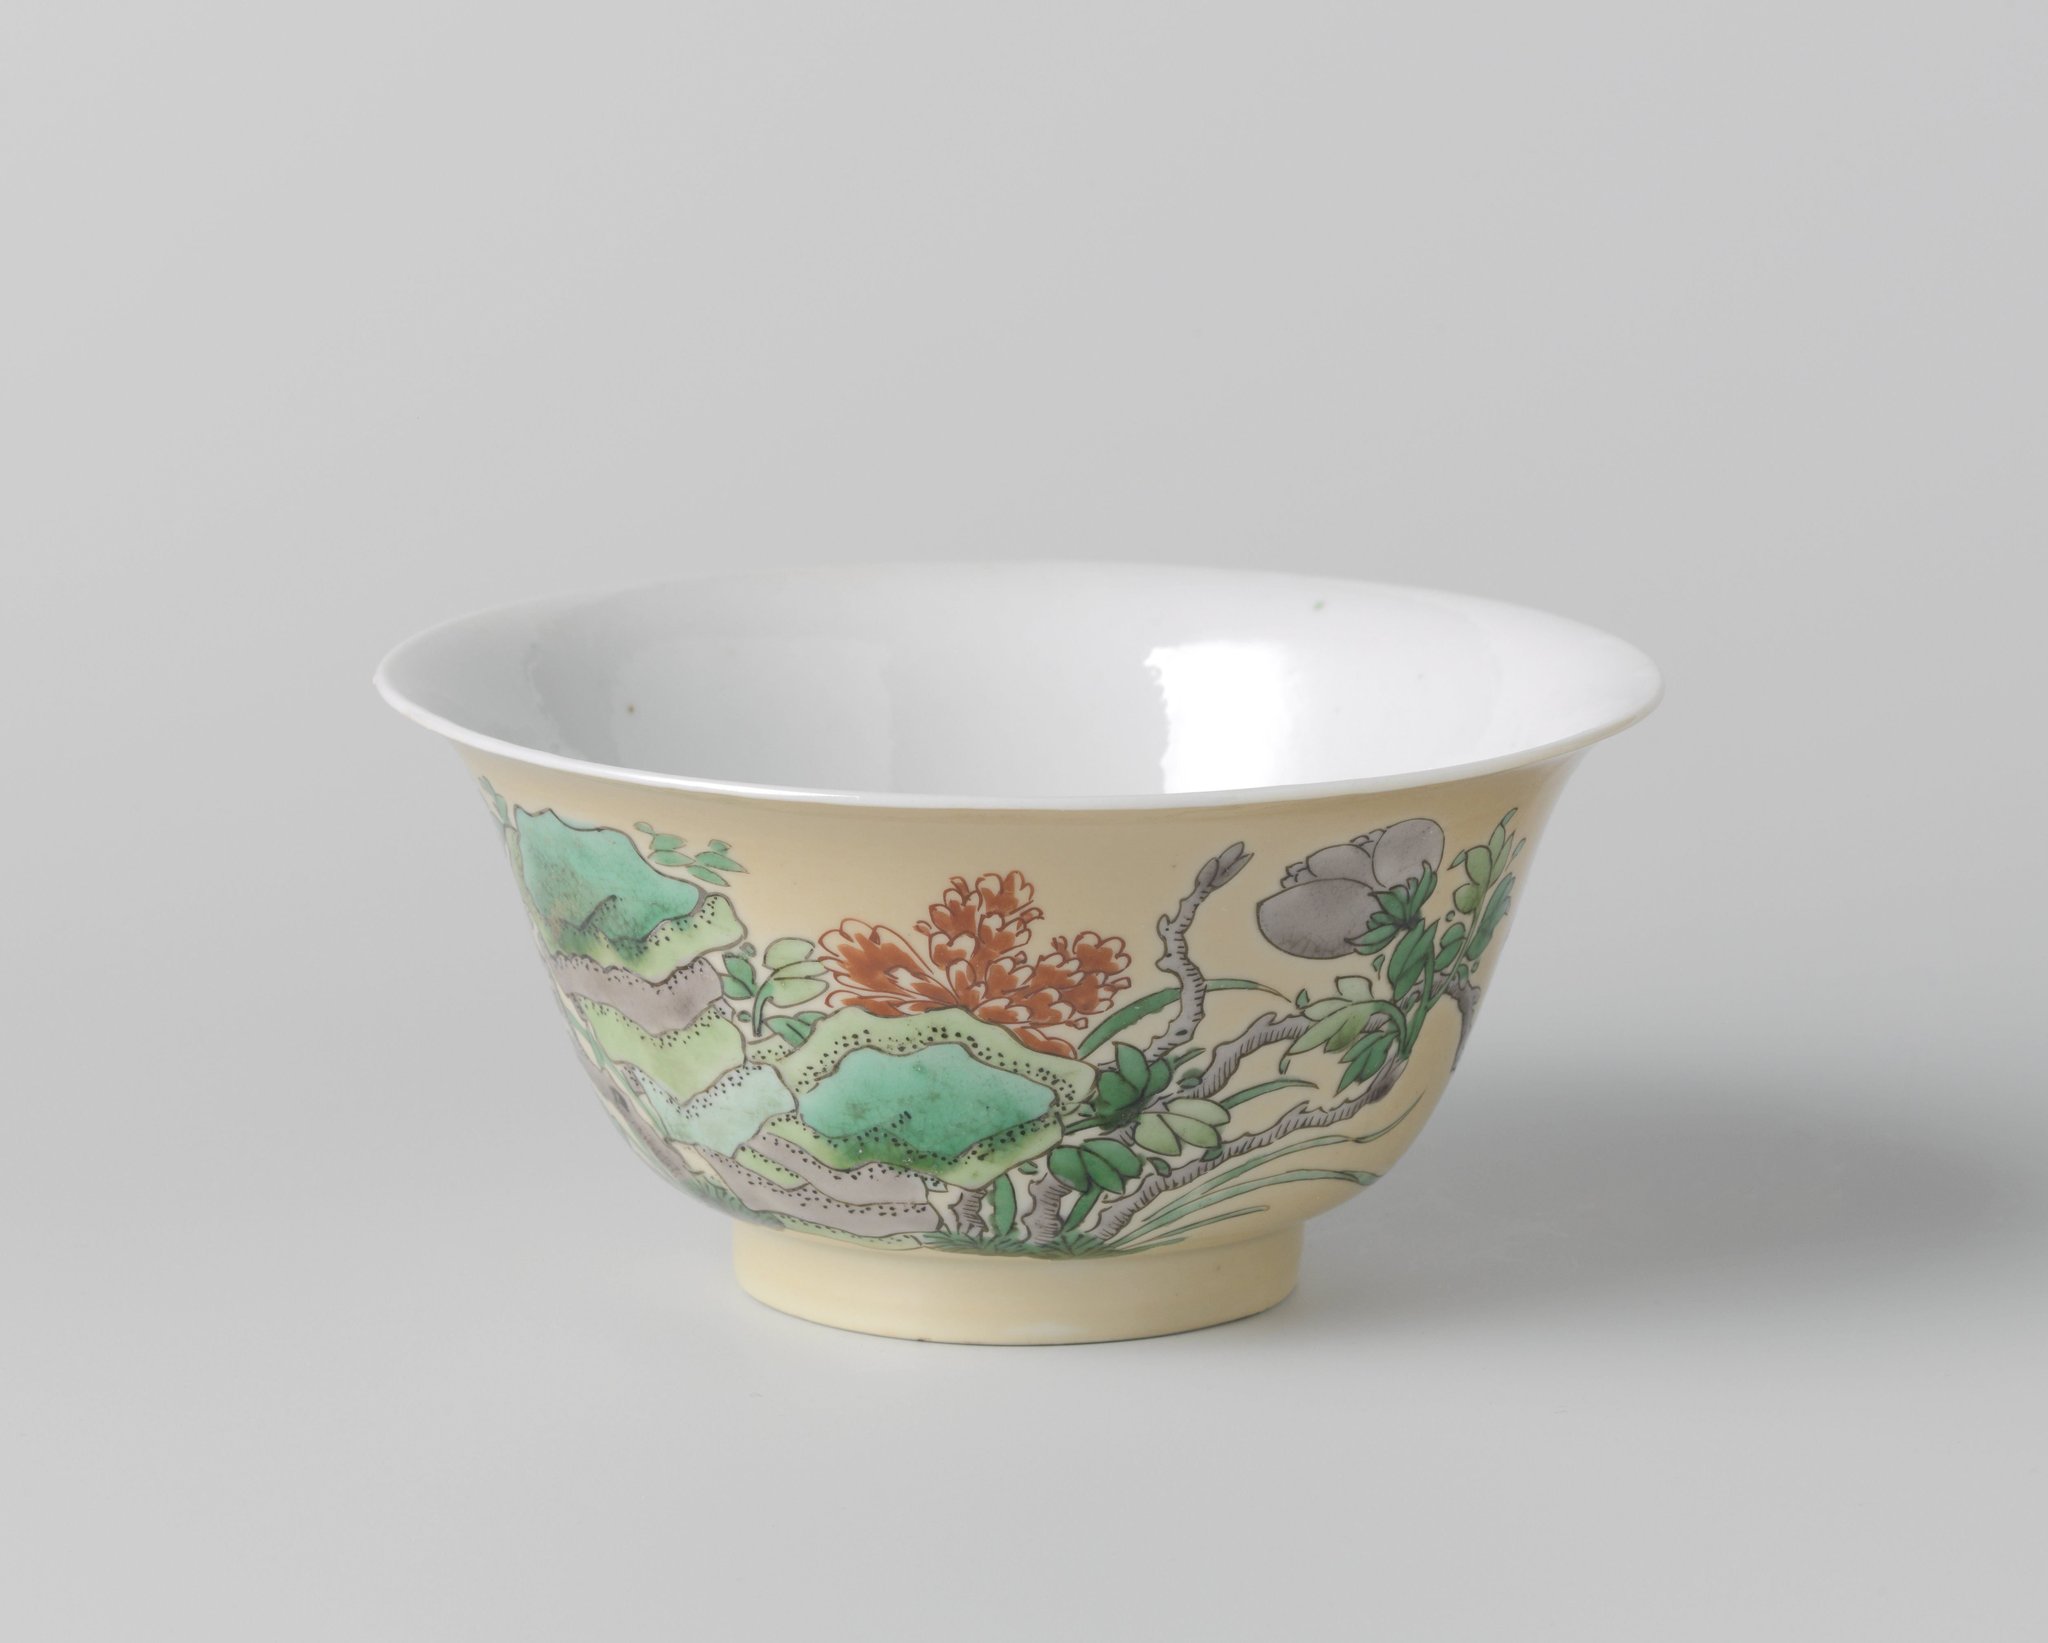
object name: bowl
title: Bell-shaped bowl with onderglaze light brown with rocks and flower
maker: Anonymous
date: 1700-1724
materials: cobalt, glaze, paint, porcelain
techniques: firing, turning, vitrification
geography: china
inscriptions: mark: ‘大 明 成 化 年 製’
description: AK-NM-6403 Twee kommen • Famille verte porselein • Onderdeel van Royers porseleinverzameling • Mogelijk onderdeel van Huygens’ porseleincollectie • Gepubliceerd: Jörg 1997, nr. 187 Deze kommen hebben een doorlopende voorstelling van bloeiende planten bij een rots, evenals het vaasje AK-NM-6428, zonder verder decoratieve elementen of compartimentering van de ruimte. Zoals daar (bij AK-NM-6428) opgemerkt, is daardoor de band met schilderingen op papier of zijde sterker dan bij de stukken met een versiering die typerend is voor porseleinen voorwerpen: een indeling in velden en decoratieve banden. Een kom als deze is een verre echo van hoogtepunten van veelkleurig beschilderd porselein zoals bewaard in de collectie van het Palace Museum in Taipei [Porcelain with painted enamels 2013]. Voor doorgewinterde porseleinliefhebbers is een vergelijking met een keizerlijk stuk porselein zin- en betekenisloos omdat het Chinese hof en een porseleinwerkplaats die levert aan Europese kooplieden, te ver van elkaar liggen voor een zinvolle vergelijking. Maar ik vind de overeenkomst opmerkelijk al verschilt de verfijning natuurlijk zeer. Ik vind het boeiend te zien hoe het ultieme doel (de kom in het paleis) wordt vertaald tot verhandelbare serie-producten. Het blijft naar mijn idee waar dat een afspiegeling van die perfecte kom in Europa arriveerde en gehanteerd en bewonderd werd. Royer kan de overeenkomst met schilderkunst ook opgemerkt hebben. Hij had een serie albums met bloeiende planten die op een vergelijkbare manier zijn geschilderd: bij een rots en met een verder lege achtergrond (Museum Volkenkunde 360-382, voor een gestileerde rots met bloemen, zie bijvoorbeeld 360-382h21). Door de café au lait achtergrond kunnen deze kommen ook gerekend worden tot de monochromen, een type porselein dat in China zeer geliefd was, in Frankrijk in de achttiende eeuw een echt verzamelonderwerp, maar in Nederland nauwelijks op belangstelling kon rekenen. Zoals bij de inleiding bij het bleu poudré uitgelegd zijn het café au lait en bleu poudré de enige monochrome glazuren die in enige hoeveelheden aanwezig waren in Nederland in de Kangxi-periode. Mogelijk verwierf Royer deze kommen in 1786 toen hij een groot aantal stukken porselein kocht uit de nalatenschap van zijn oudtante Susanna Louise Huygens (1714-1785). In de beschrijving van haar inboedel zijn bij het gekleurde porselein ‘Twee dito [kommen geele grond] met bloemwerk, waarvan een defect’ te vinden. Het defect zou de chip in de rand van AK-NM-6403-a kunnen zijn. Bronnen: Christiaan J.A. Jörg, Chinese ceramics in the collection of the Rijksmuseum, Amsterdam: the Ming and Qing dynasties, Londen, 1997. Porcelain with painted enamels of Qing Yongzheng period (1723-1735) (cat. National Palace Museum), Taipei, 2013.